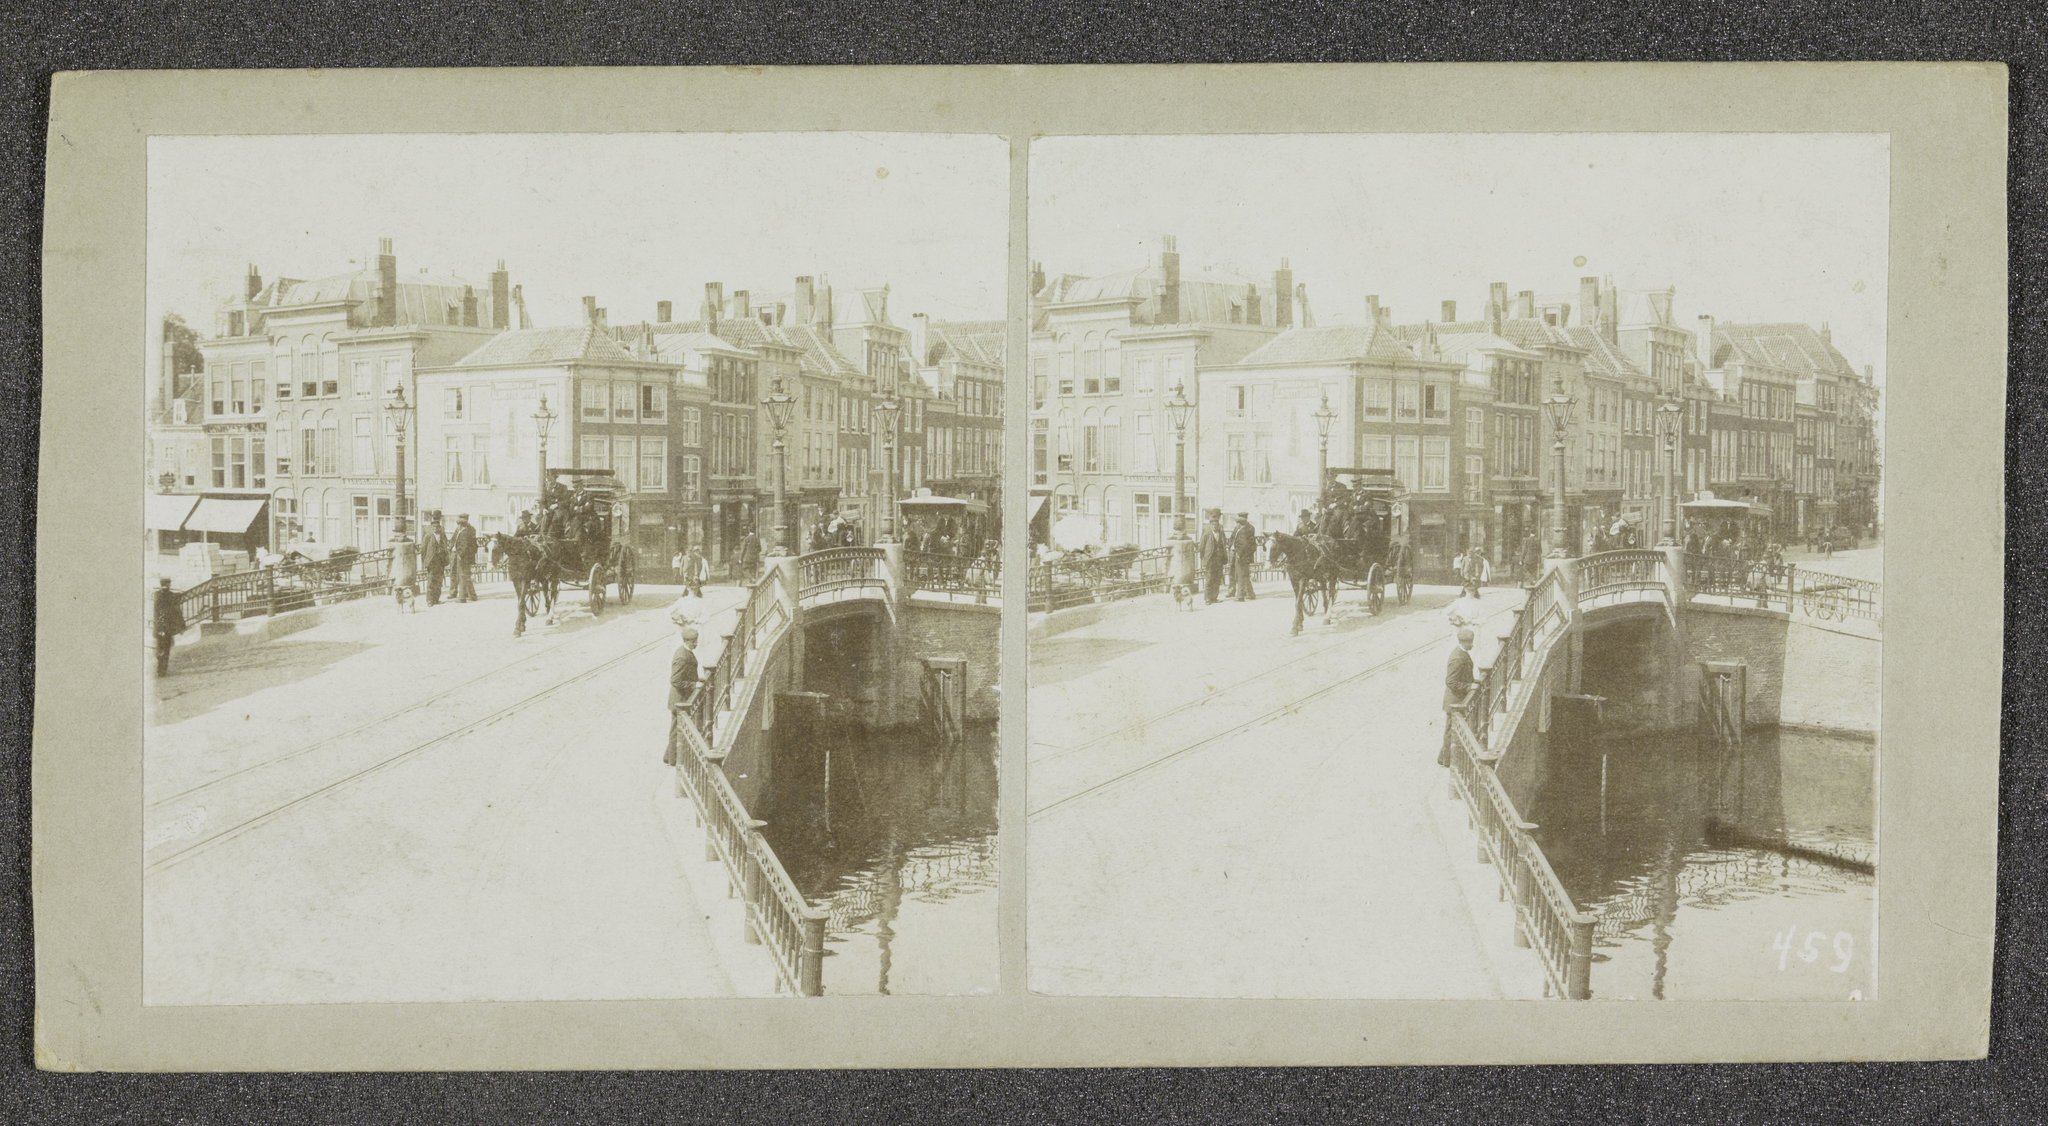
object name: stereograph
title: Gezicht op de Wagenbrug in Den Haag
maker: wilhelm frederick antonius delboy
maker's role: fotograaf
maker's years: 1853-1928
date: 1884-1928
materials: cardboard, photographic support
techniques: collodion silver print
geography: the hague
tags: urban housing, bridge in city across river, canal, etc.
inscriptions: inscription: ‘DELBOIJ/ Fotograaf/ Passage 22/ DEN HAAG’, number: ‘459’